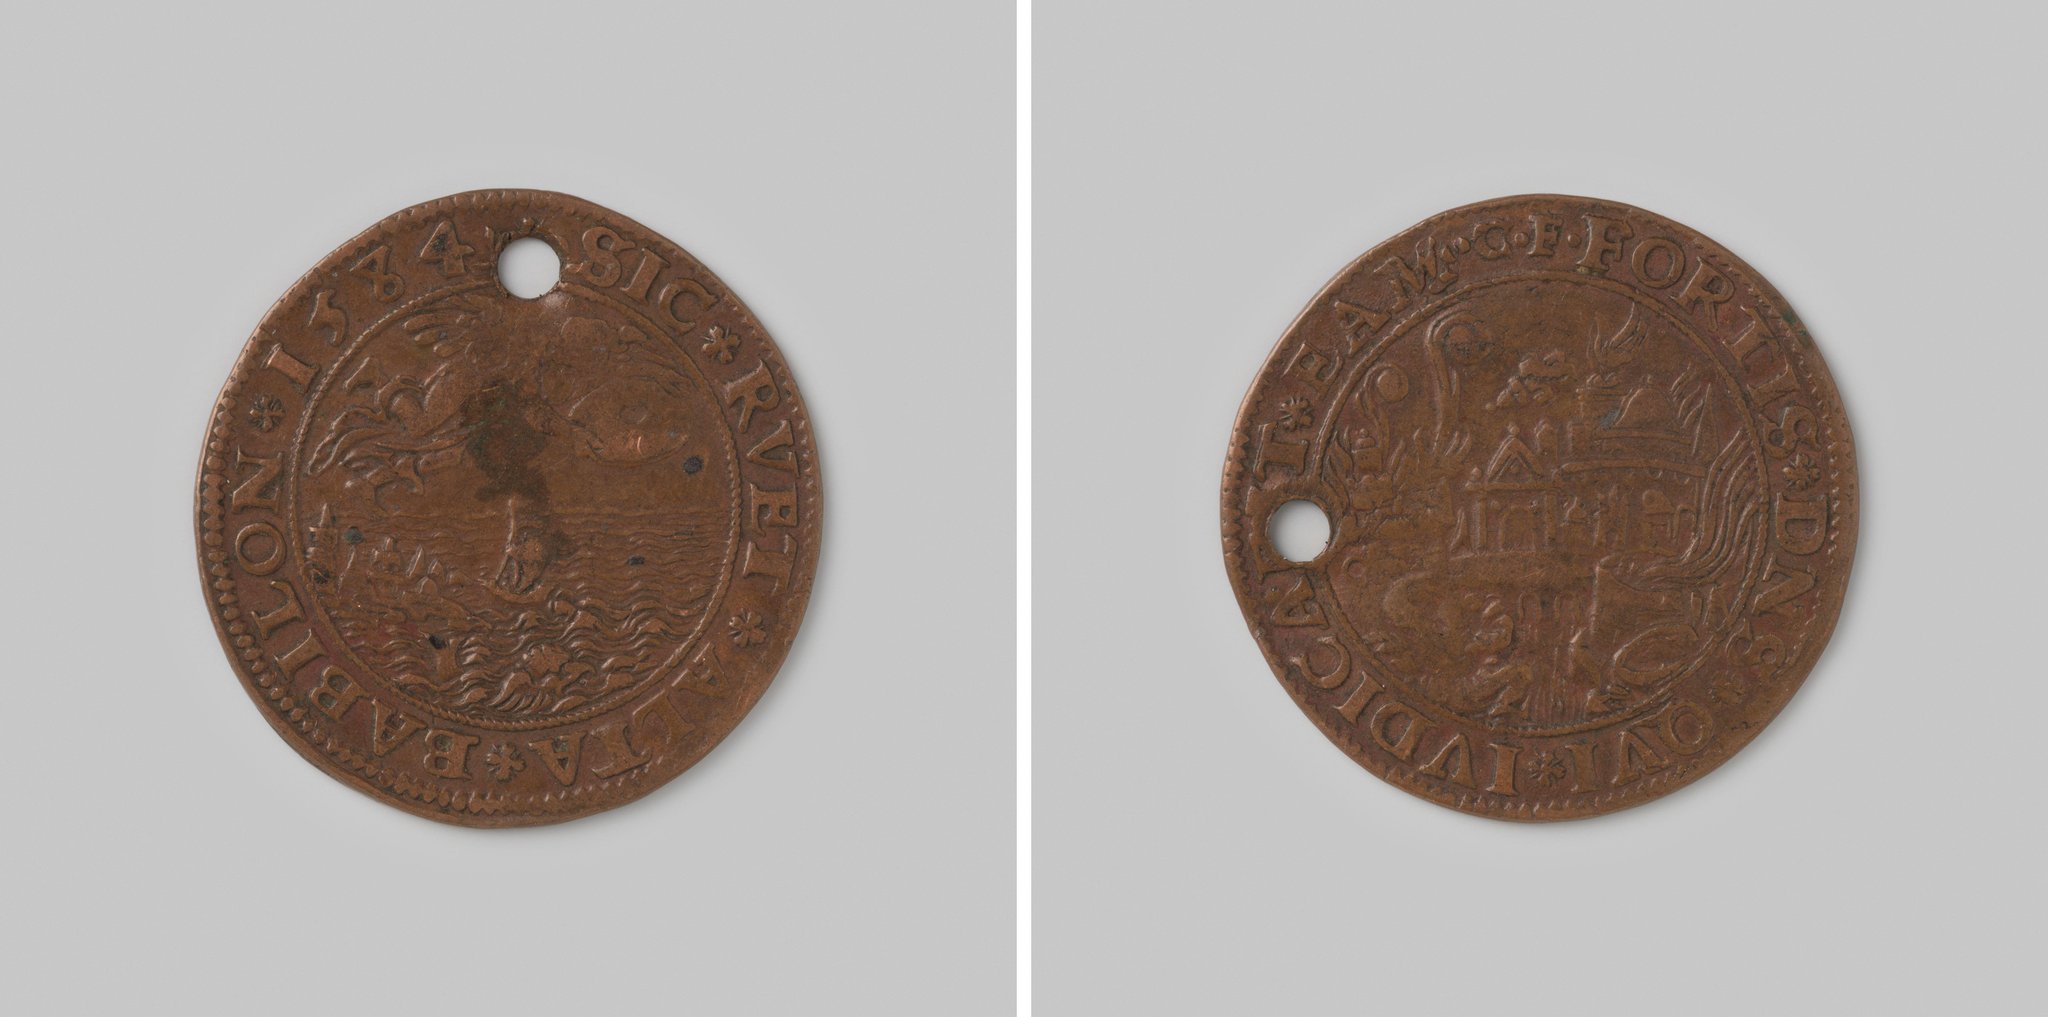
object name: jeton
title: Rekenpenning uit Antwerpen op het handhaven van de Hervormde Godsdienst 1584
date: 1584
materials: copper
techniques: striking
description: Koperen penning met doorboring, op de voorzijde een engel met een molensteen boven een haven en scheepje op zee, met omschrift, op de keerzijde een brandende stad met omschrift.